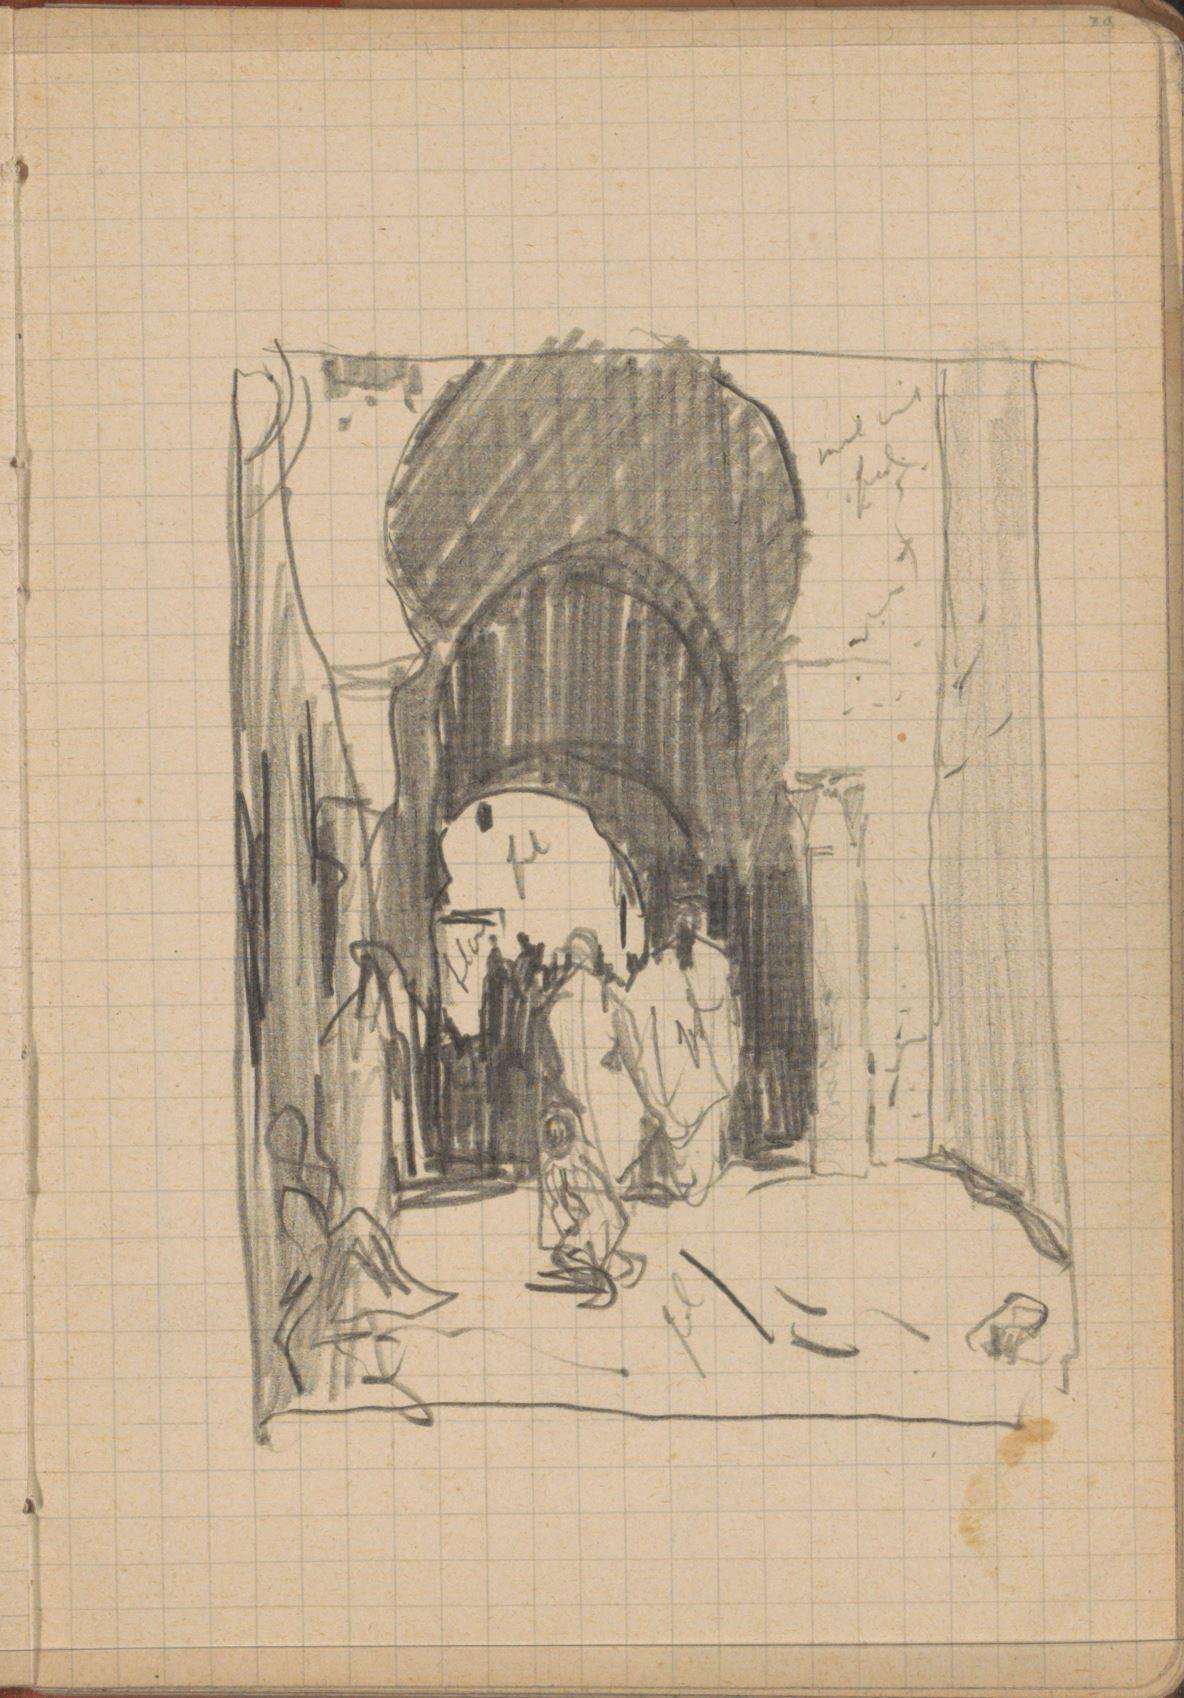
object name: sketchbook leaf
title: Figuren in een deels overdekte straat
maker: marius bauer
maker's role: draughtsman, print maker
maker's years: 1867-1932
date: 1909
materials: pencil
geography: tunis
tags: street (+ city(-scape) with figures, staffage)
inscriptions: kleurnotitie, handgeschreven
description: Pagina 39 uit een schetsboek met 67 bladen.